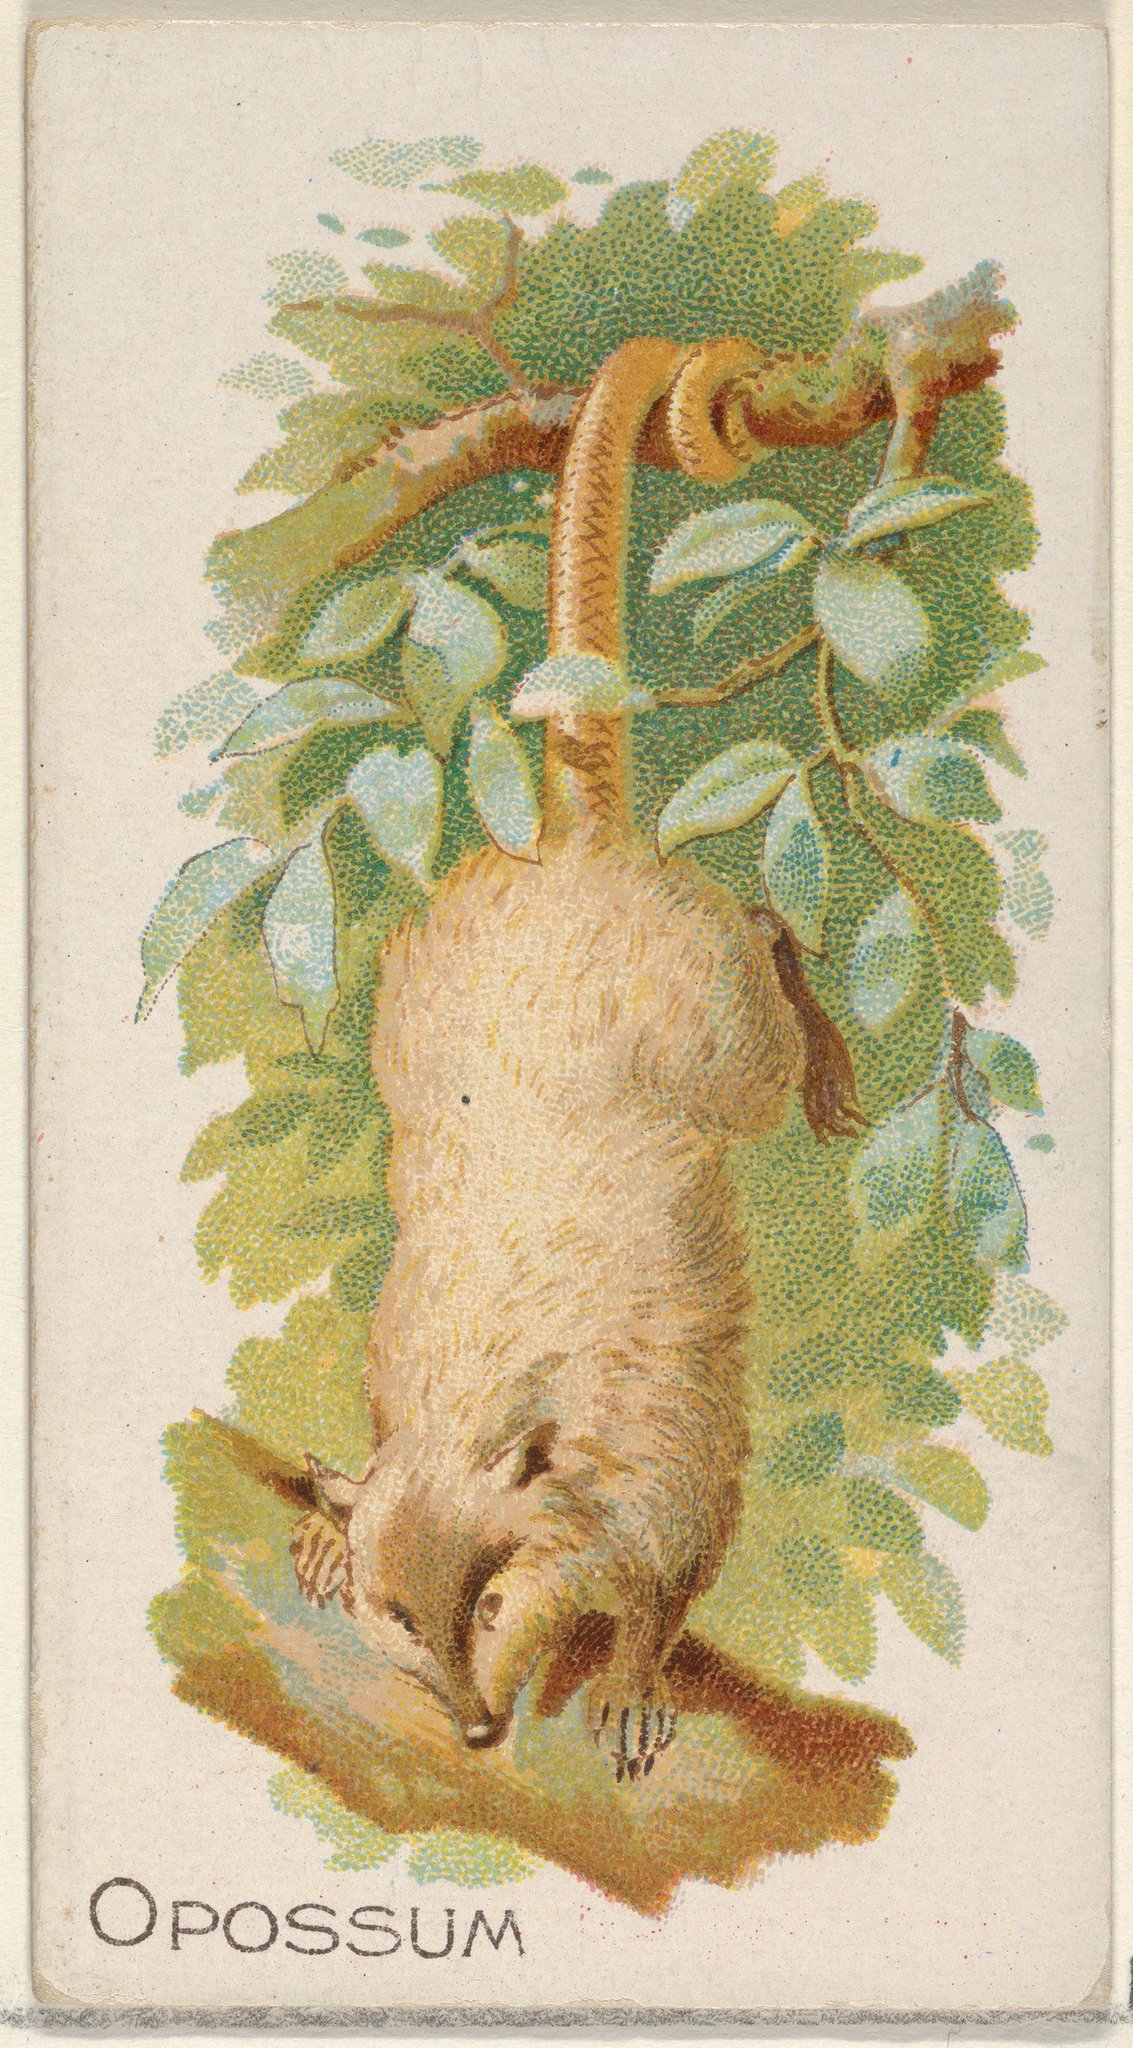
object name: print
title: Opossum, from the Quadrupeds series (N21) for Allen & Ginter Cigarettes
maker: allen & ginter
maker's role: publisher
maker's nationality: american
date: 1890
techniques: color lithograph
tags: animals